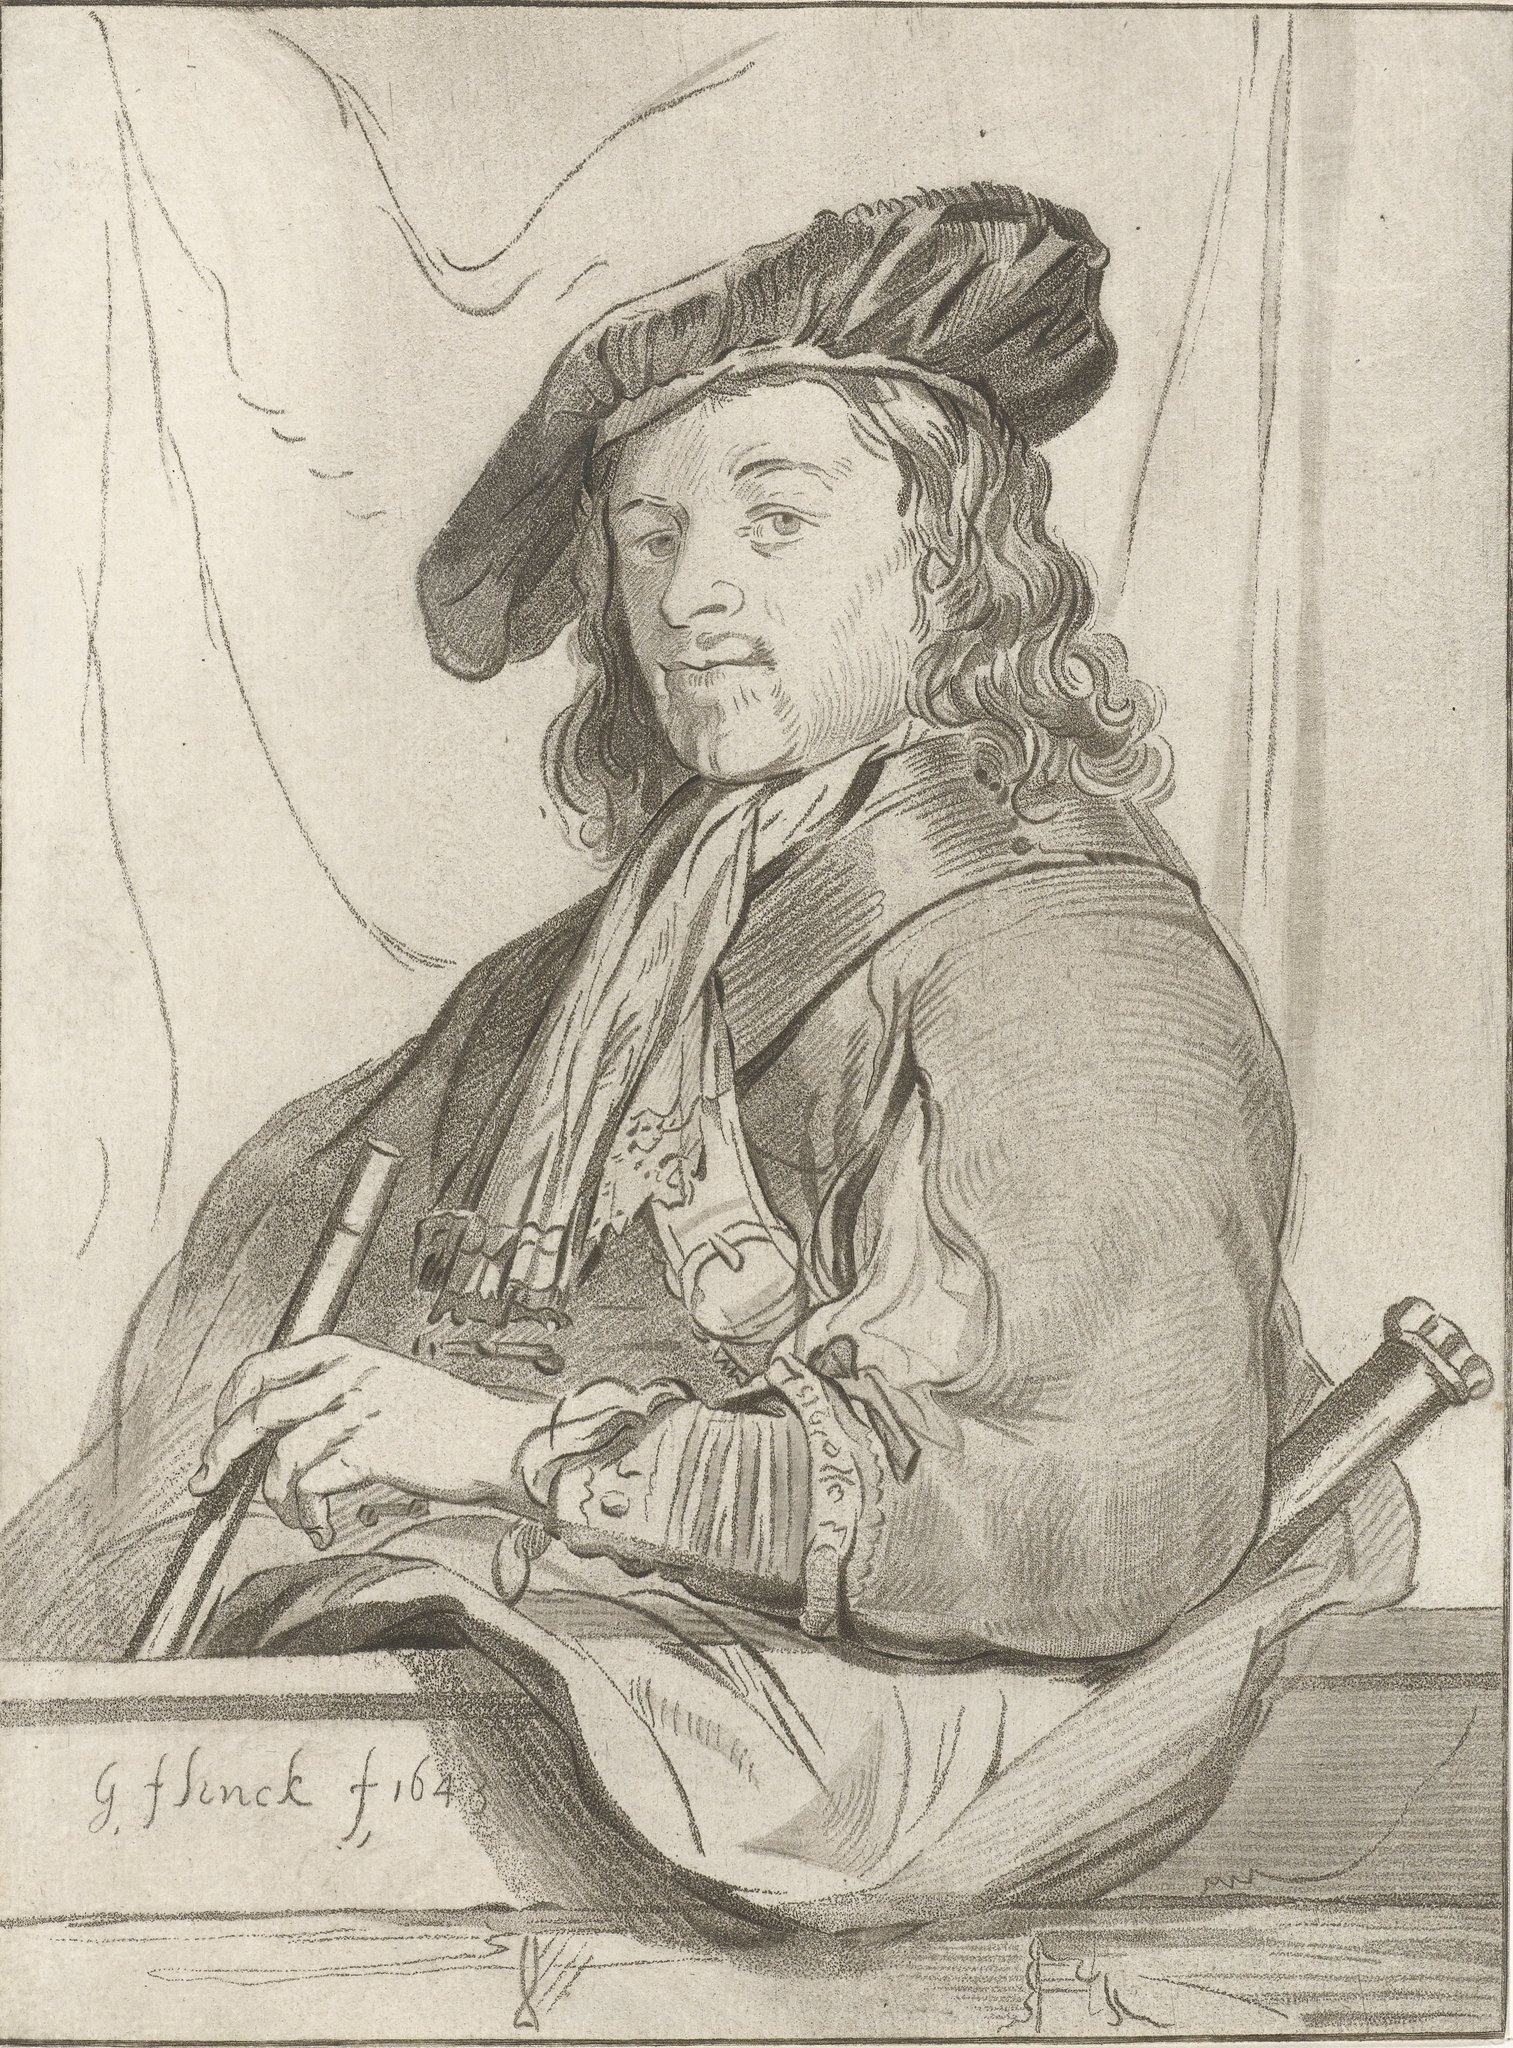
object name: print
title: Man bij borstwering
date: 1773-1774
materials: paper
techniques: printmaking, roulette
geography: amsterdam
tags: head-gear: cap (+ men's clothes), binoculars, spy-glass, etc.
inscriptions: inscription: ‘Govt. Flick. del. 1648. Ploos van Amstel. J.C. Fecit. 1773’, collector's mark: Lugt 2725, collector's mark: Lugt 240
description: Achter een borstwering staat een man met een baret op zijn hoofd en een verrekijker in zijn hand.